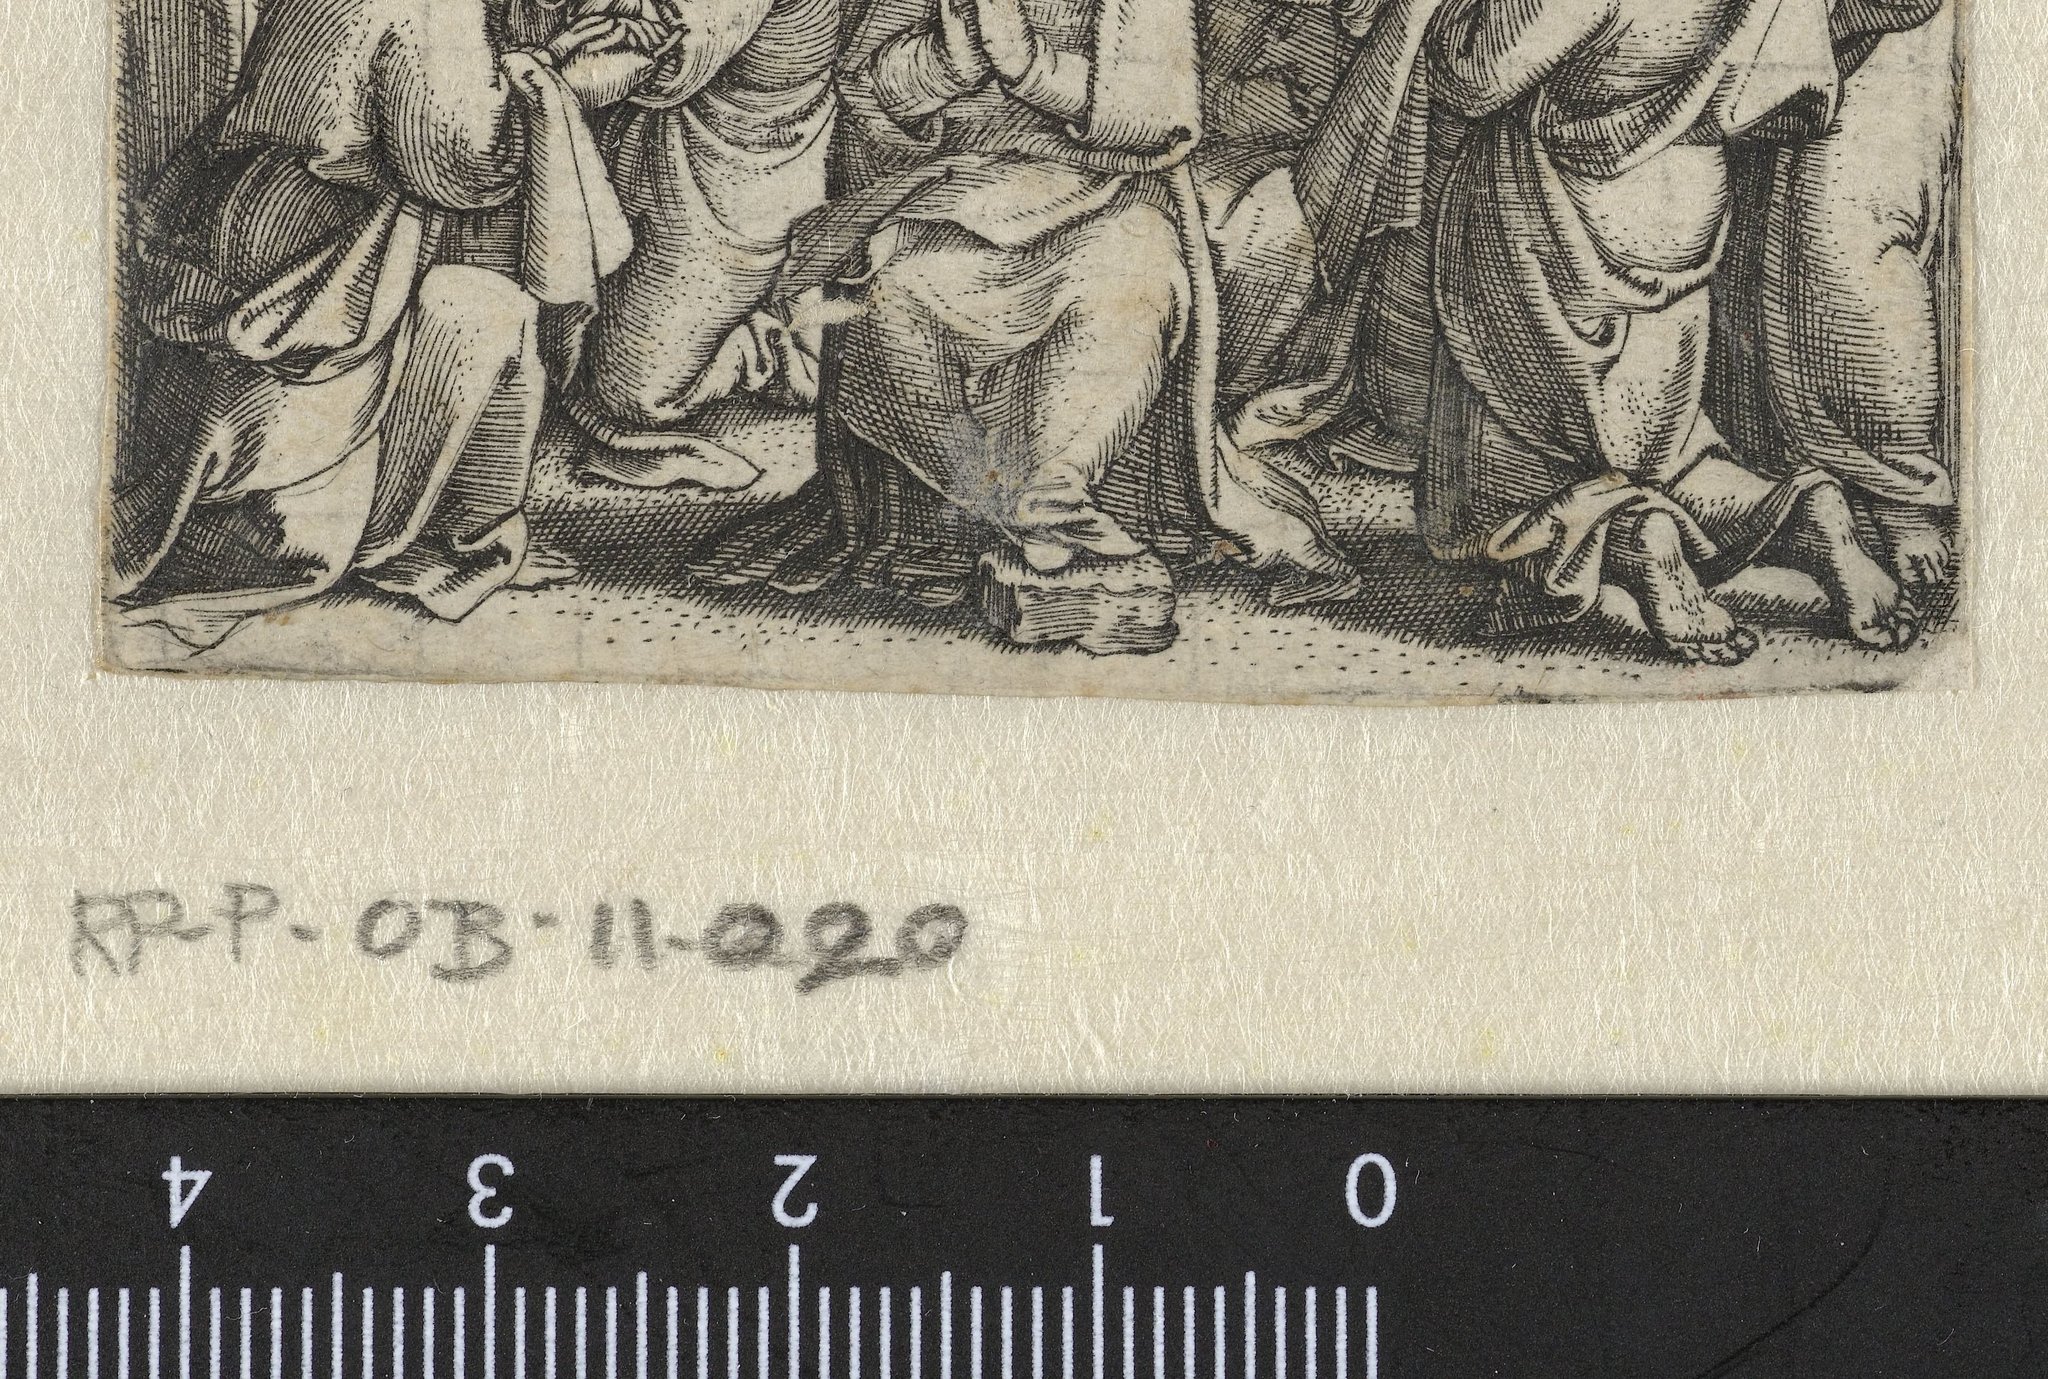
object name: print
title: Uitstorting van de Heilige Geest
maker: georg pencz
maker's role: draughtsman, painter, print maker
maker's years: 1500-1550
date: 1534-1535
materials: paper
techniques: engraving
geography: germany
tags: pentecost: the holy ghost descends upon (mary and) the apostles, sometimes paul and/or representatives of the nations present (acts 2:1-4)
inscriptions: collector's mark: Lugt 240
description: Zittende Maria wordt omringd door knielende apostelen. Allen kijken naar de hemel van waar de Heilige Geest, in de vorm van een duif, hen vervuld. Als teken van deze vervulling hebben zij een soort vlam op hun hoofd.